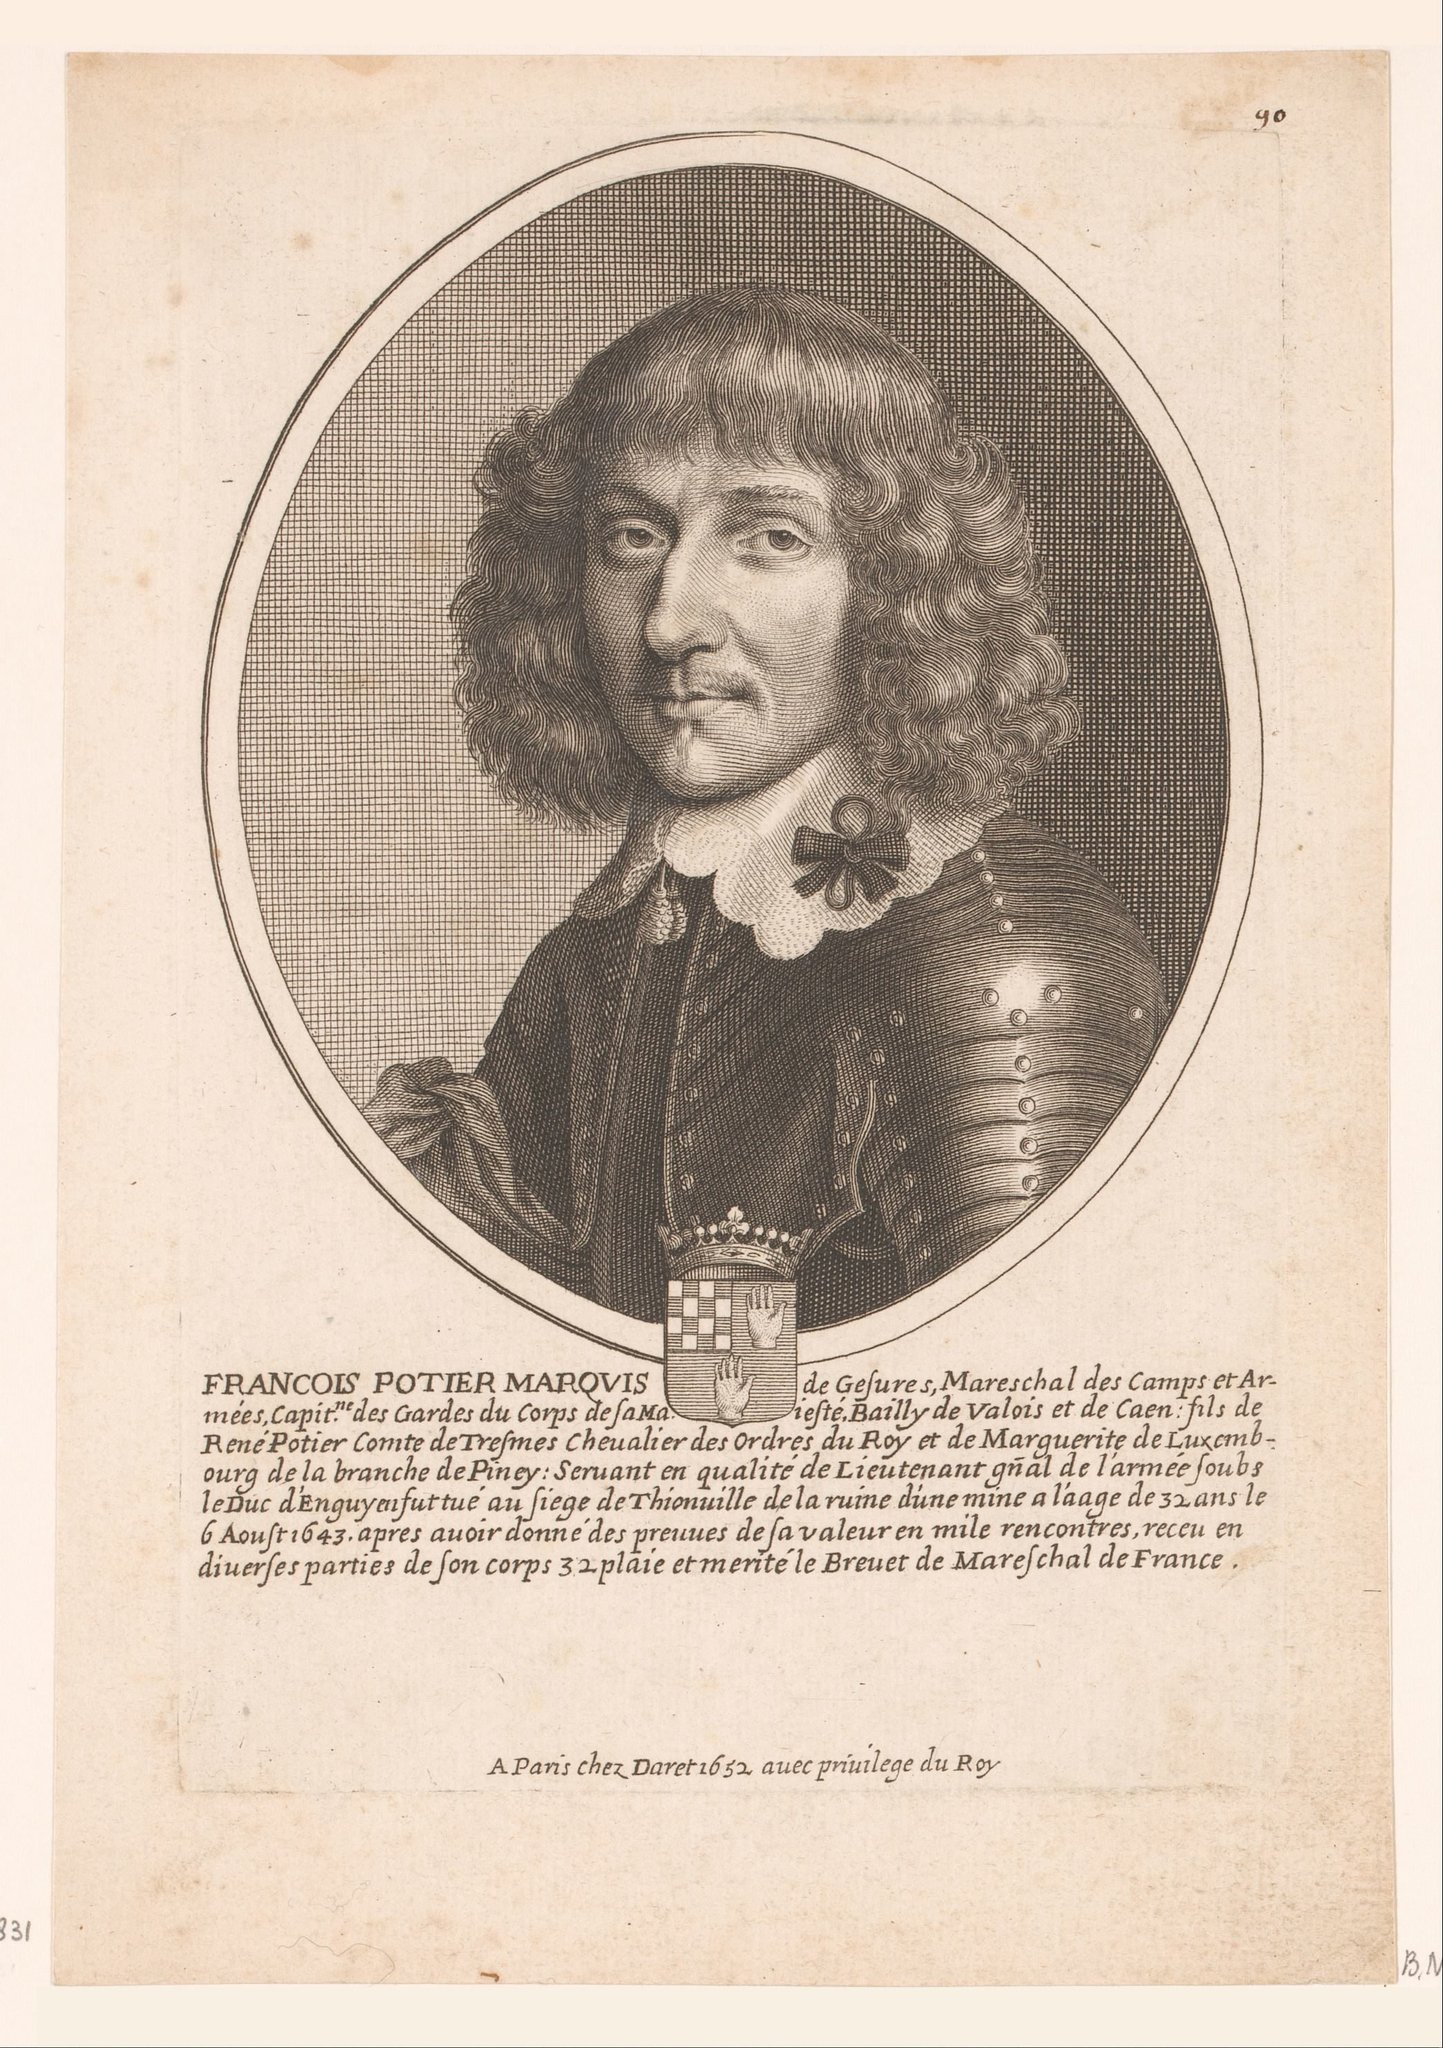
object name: print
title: Portret van François Potier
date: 1652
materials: paper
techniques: engraving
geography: paris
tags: historical persons, armorial bearing, heraldry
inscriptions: number: ‘40’, collector's mark: Lugt 2228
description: Maakt deel uit van een serie portretten getiteld 'Tableaux historiques ou sont gravez les Illustres François et Etrangiers de l'un et l'autre sexe (...)', voor het eerst uitgegeven in 1652 door Daret. Een tweede staat werd uitgegeven door Boissevin en een derde door Jollain.